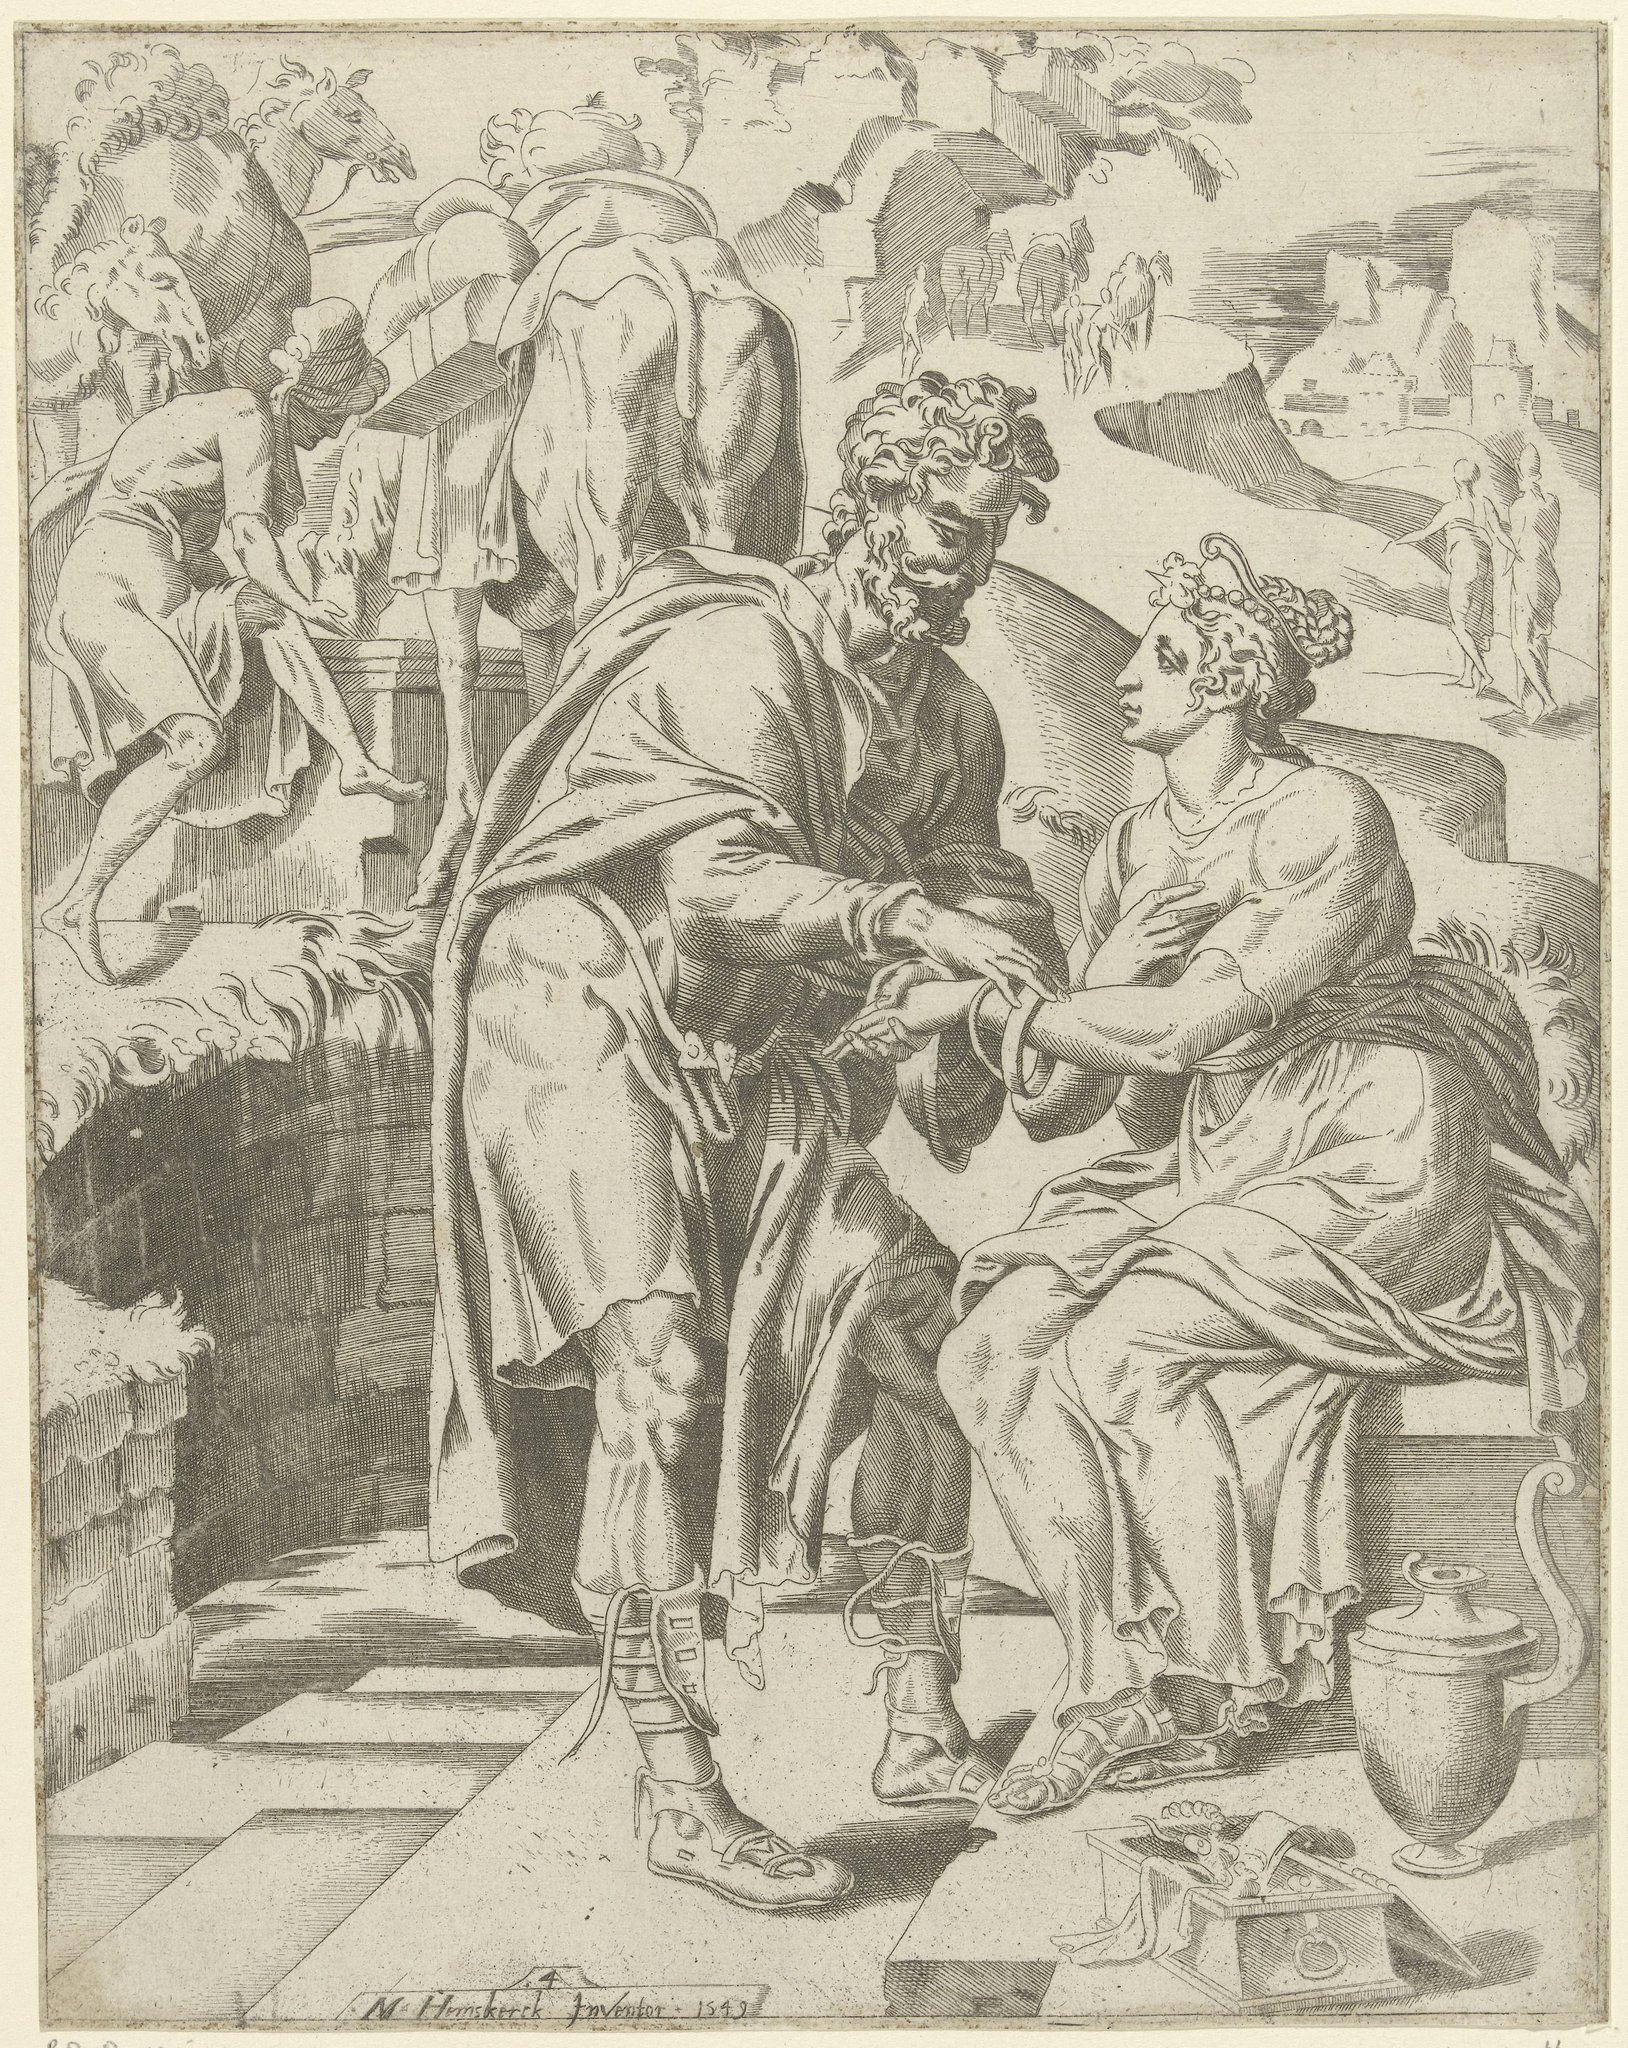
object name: print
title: Isaaks zoektocht naar een vrouw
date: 1549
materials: paper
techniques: etching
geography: haarlem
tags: rebekah receives ear-rings and golden bracelets from eliezer, rebekah returns home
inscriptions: collector's mark: Lugt 2228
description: Nadat Eliëzer en zijn kamelen hebben gedronken biedt Eliëzier Rebekka twee gouden armbanden aan. Op de achtergrond wijst Laban, Rebekka's broer Eliëzer de weg naar het ouderlijk huis. De prent maakt deel uit van een serie over Isaaks zoektocht naar een vrouw.